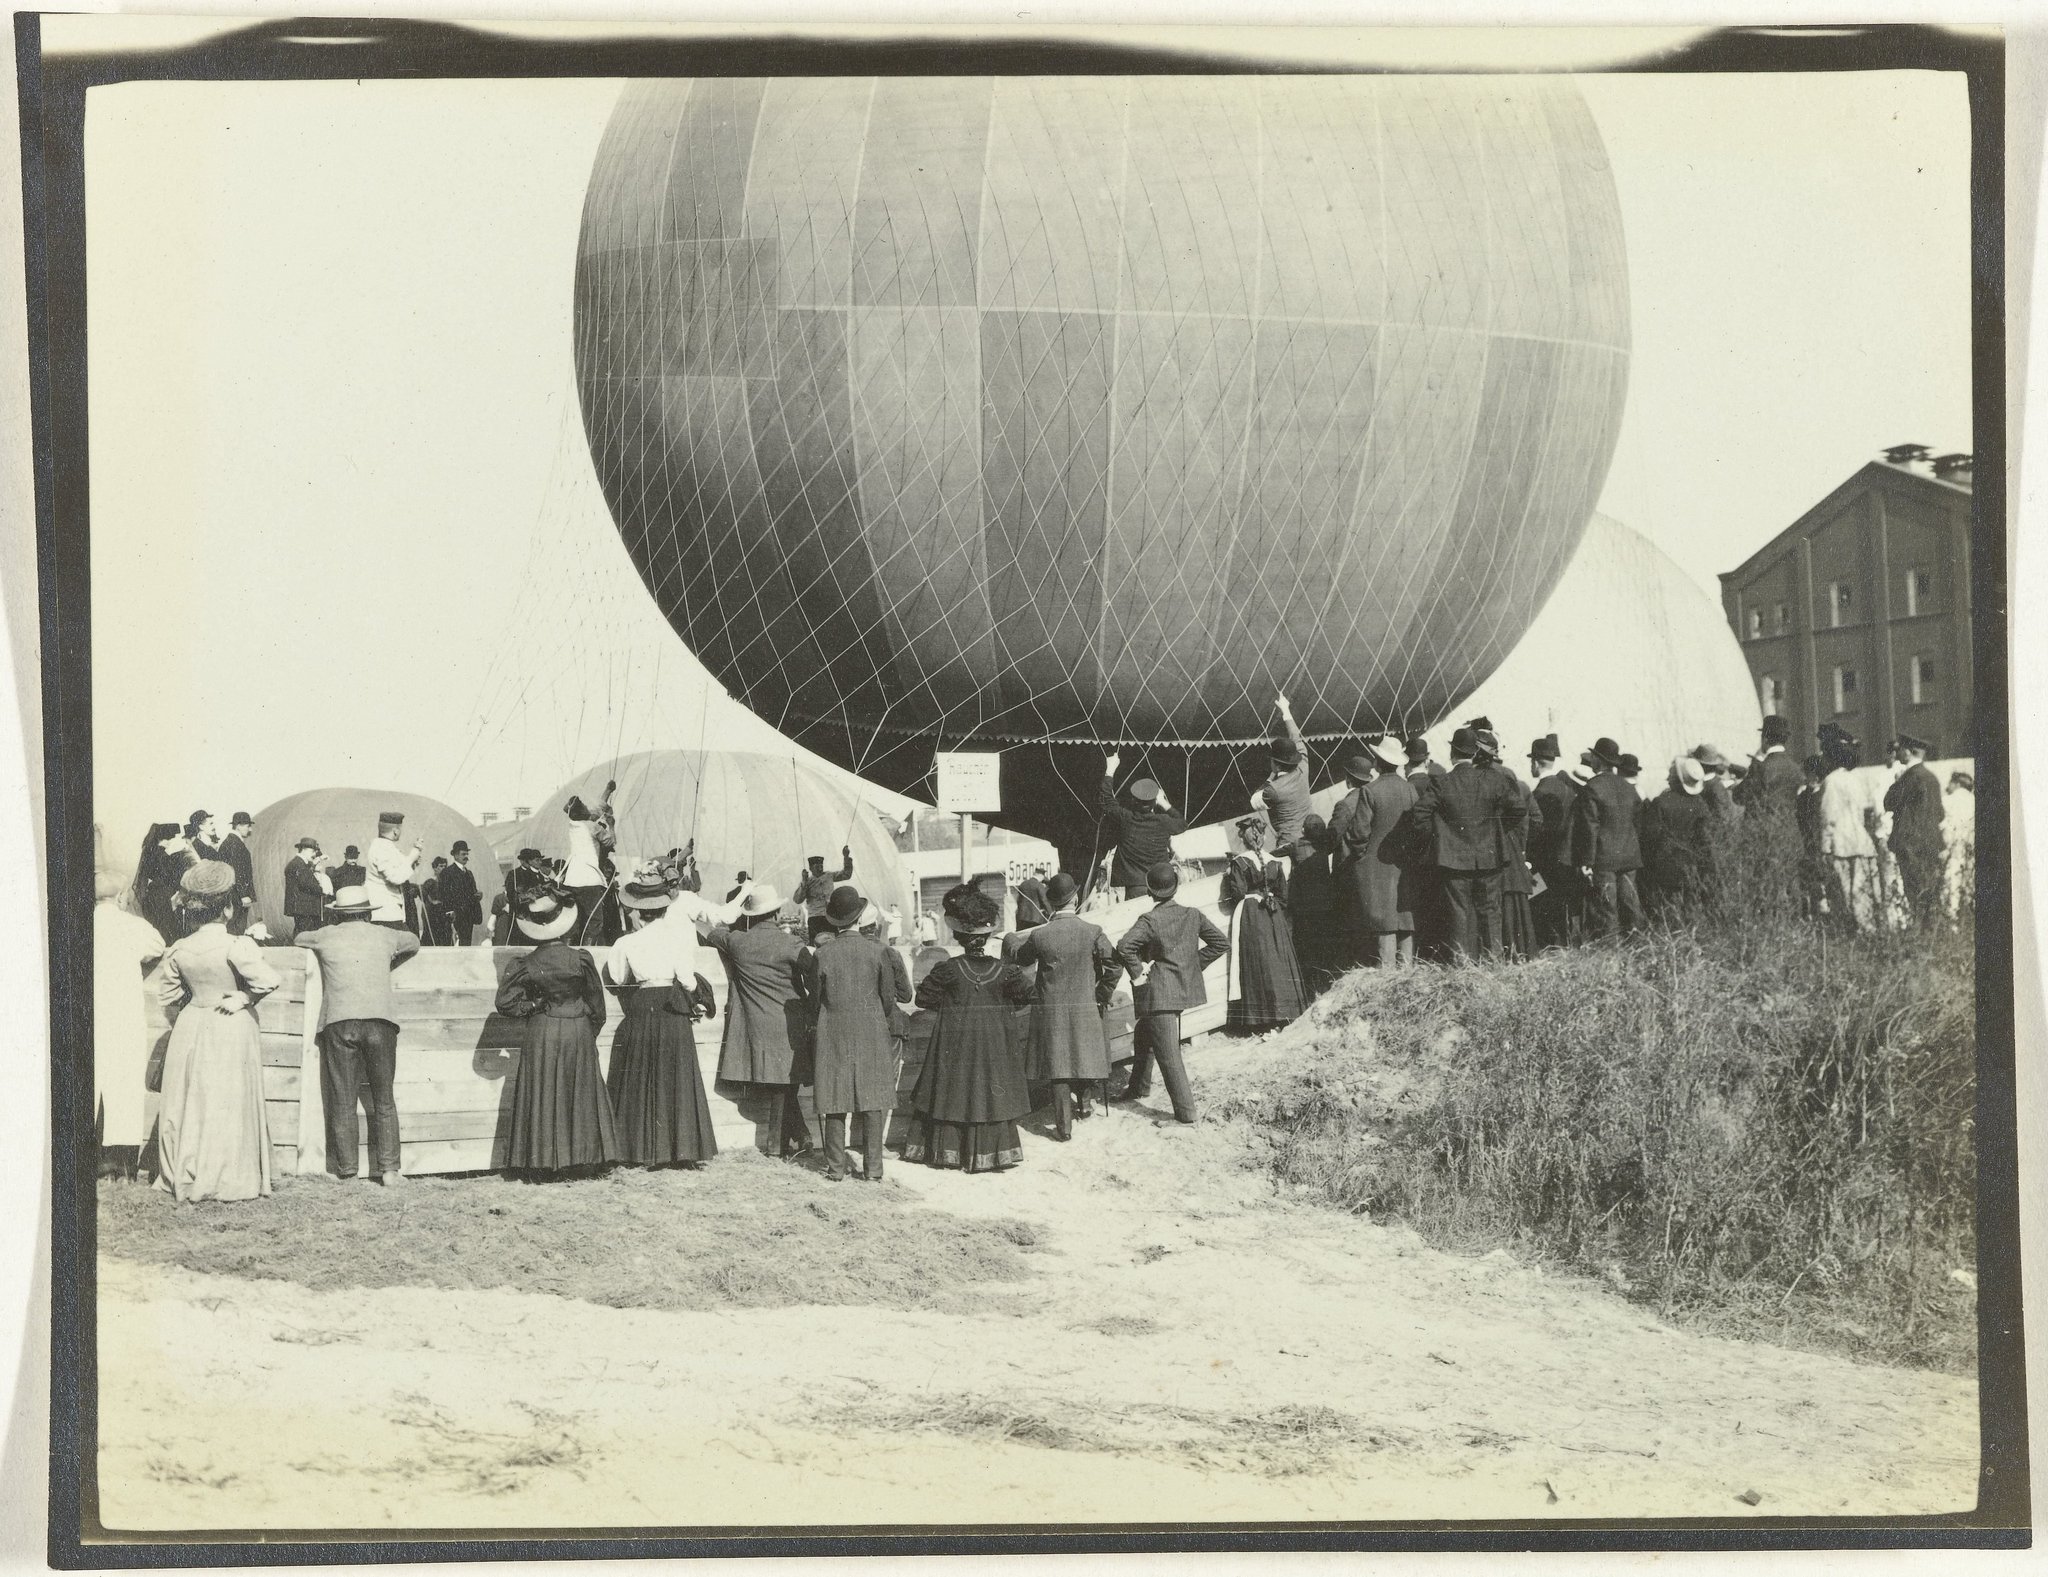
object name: photograph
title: The Third Gordon Bennett Balloon Race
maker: Anonymous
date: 1908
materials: paper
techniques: gelatin silver print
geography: schmargendorf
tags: (flying a) gas balloon, balloon flight (sport), balloon (aviation)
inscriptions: annotation: ‘Schmargendorf/ 10/10/08/ 37906’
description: Op de achtergrond worden de drie ballonnen opgeblazen. Op de voorgrond enige tientallen mensen publiek.